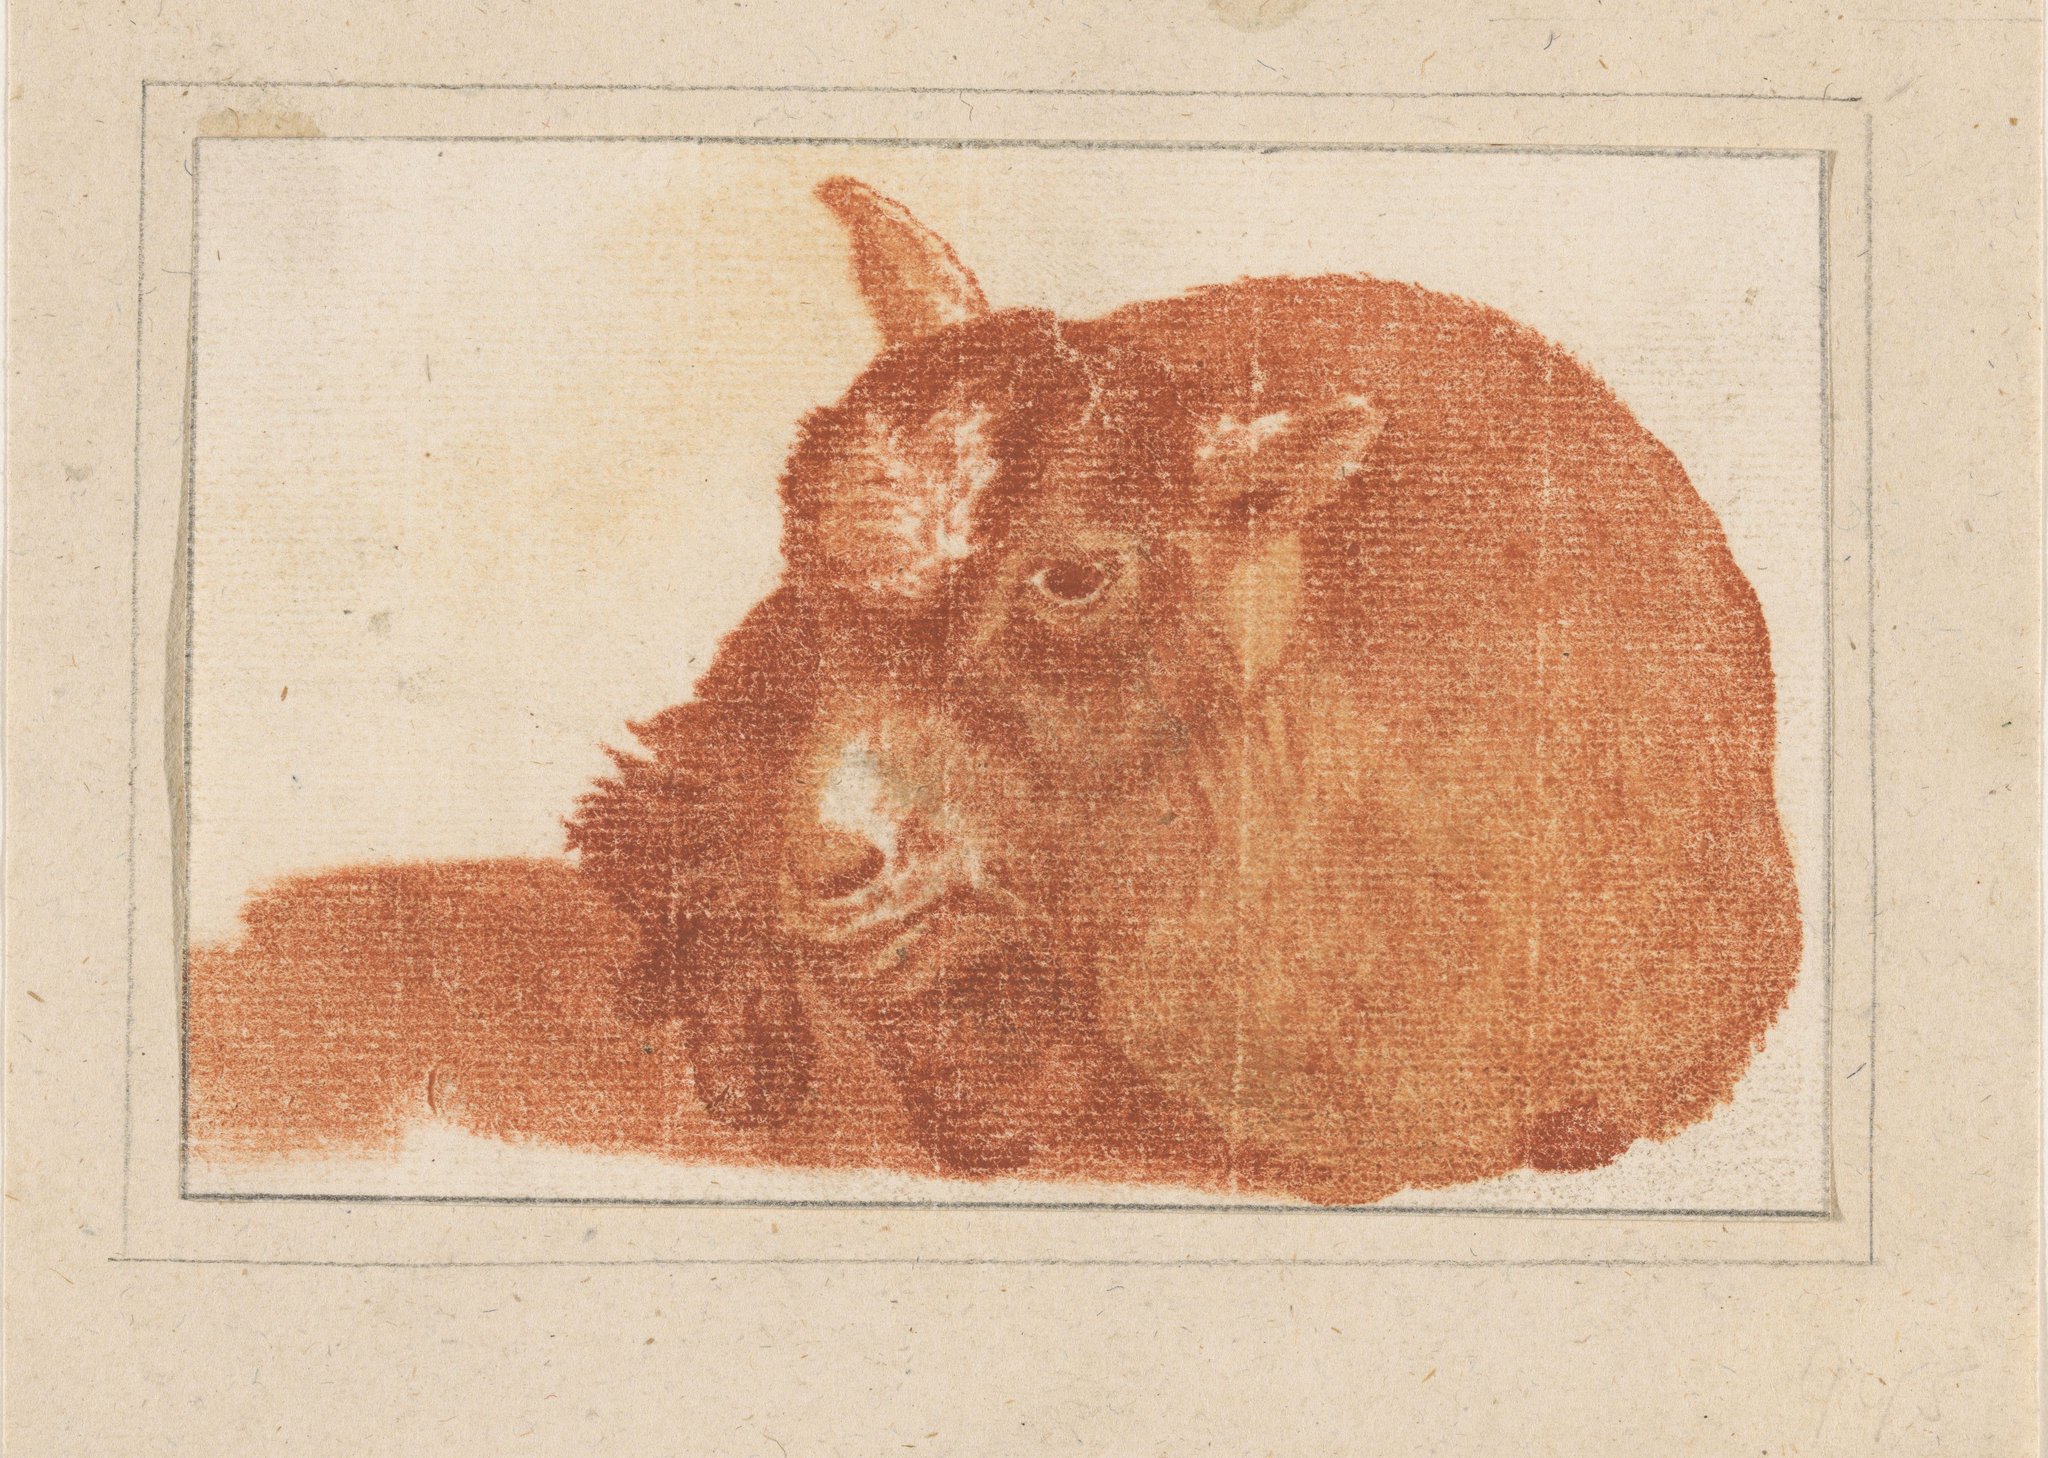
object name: drawing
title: Liggend schaap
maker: Anonymous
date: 1800-1900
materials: chalk, paper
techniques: printmaking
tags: sheep